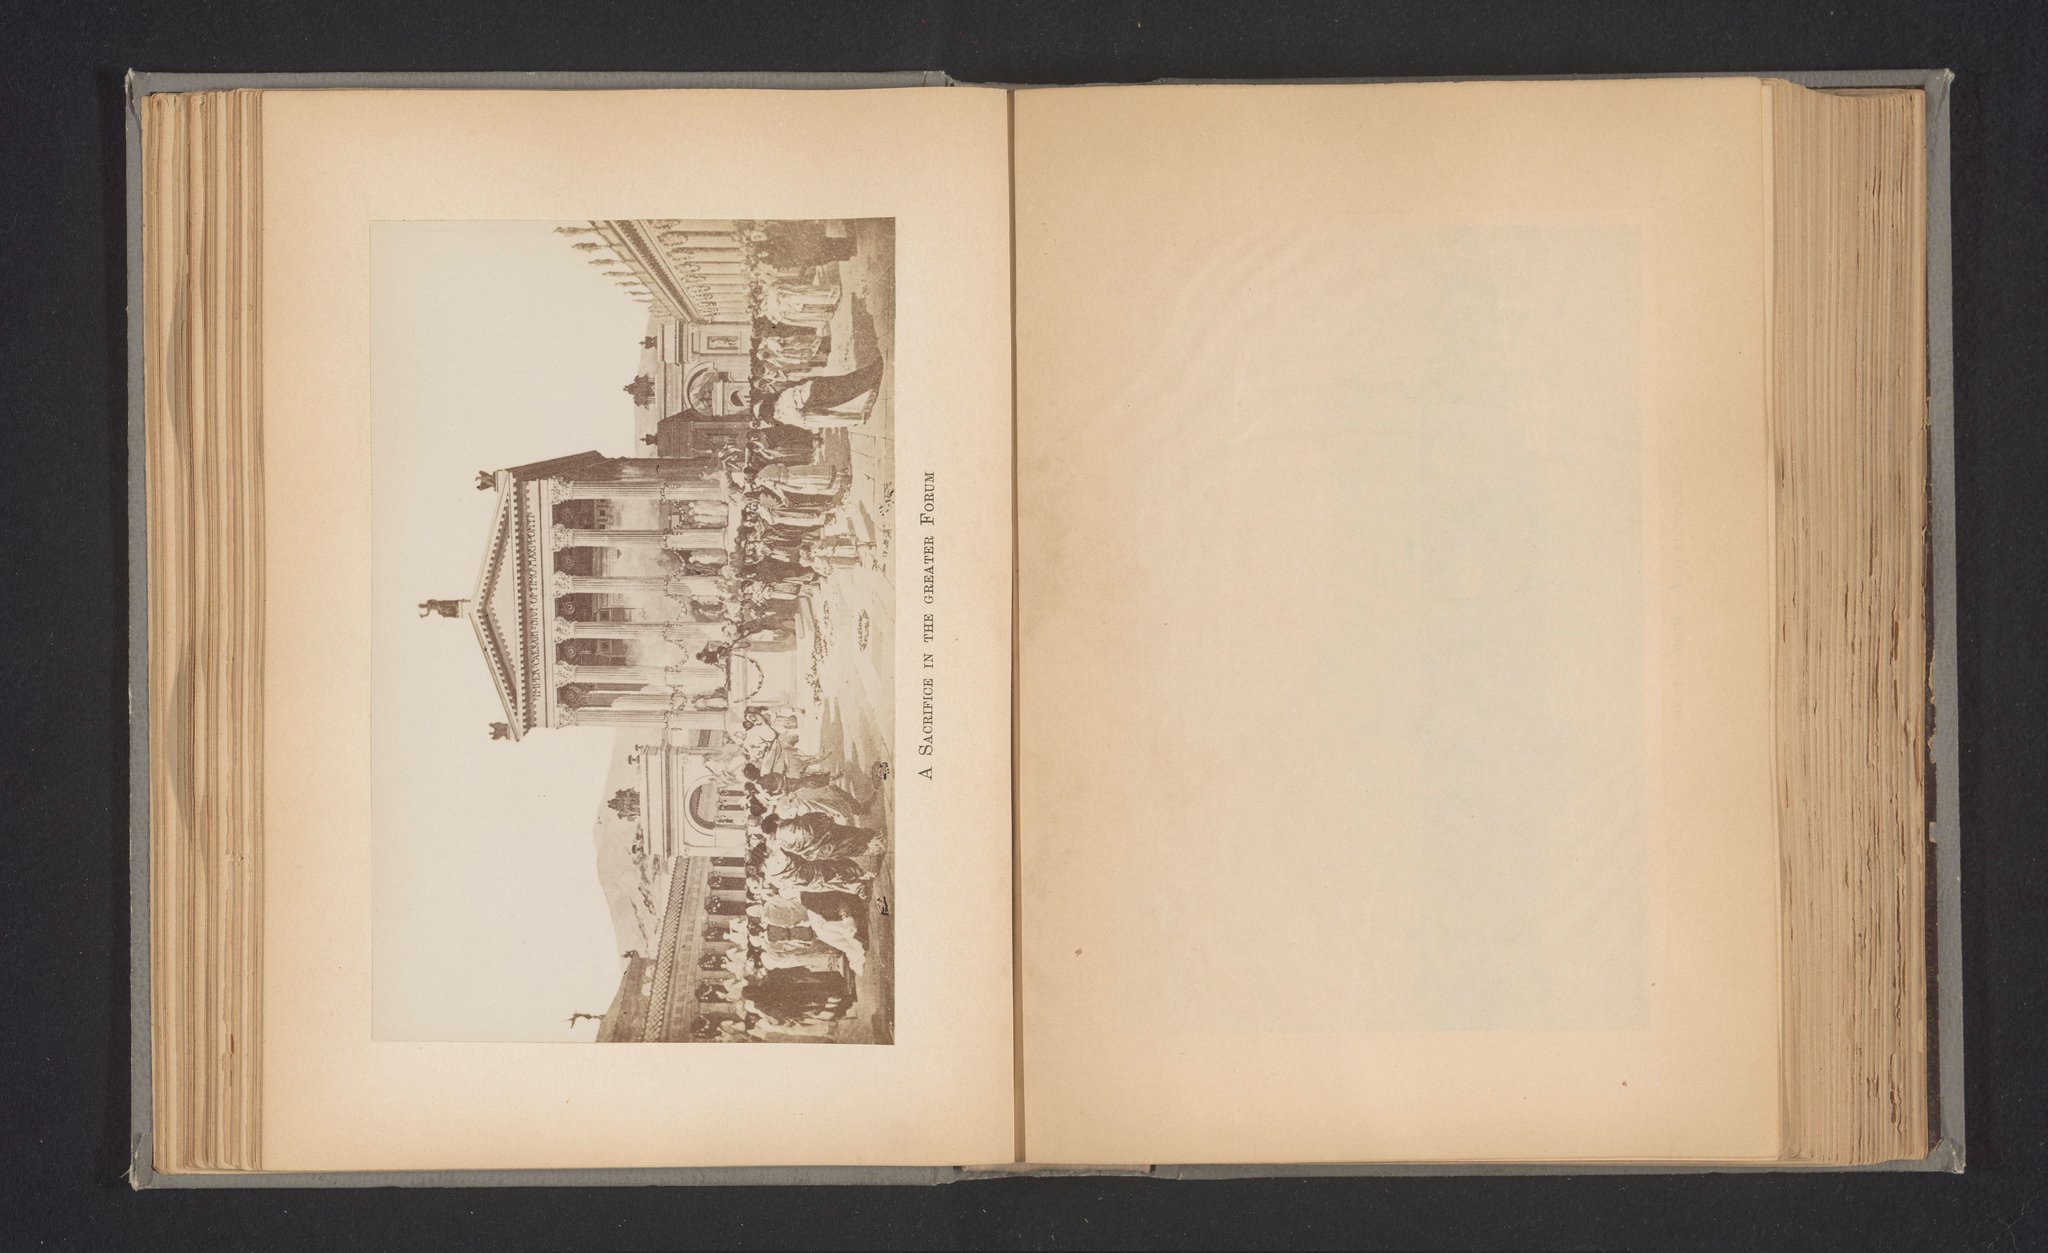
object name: reproduction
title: A sacrifice in the greater Forum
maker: Anonymous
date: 1890-1895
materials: photographic support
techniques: albumen print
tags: column, pillar ~ architecture, civic architecture; edifices; dwellings, pompeii